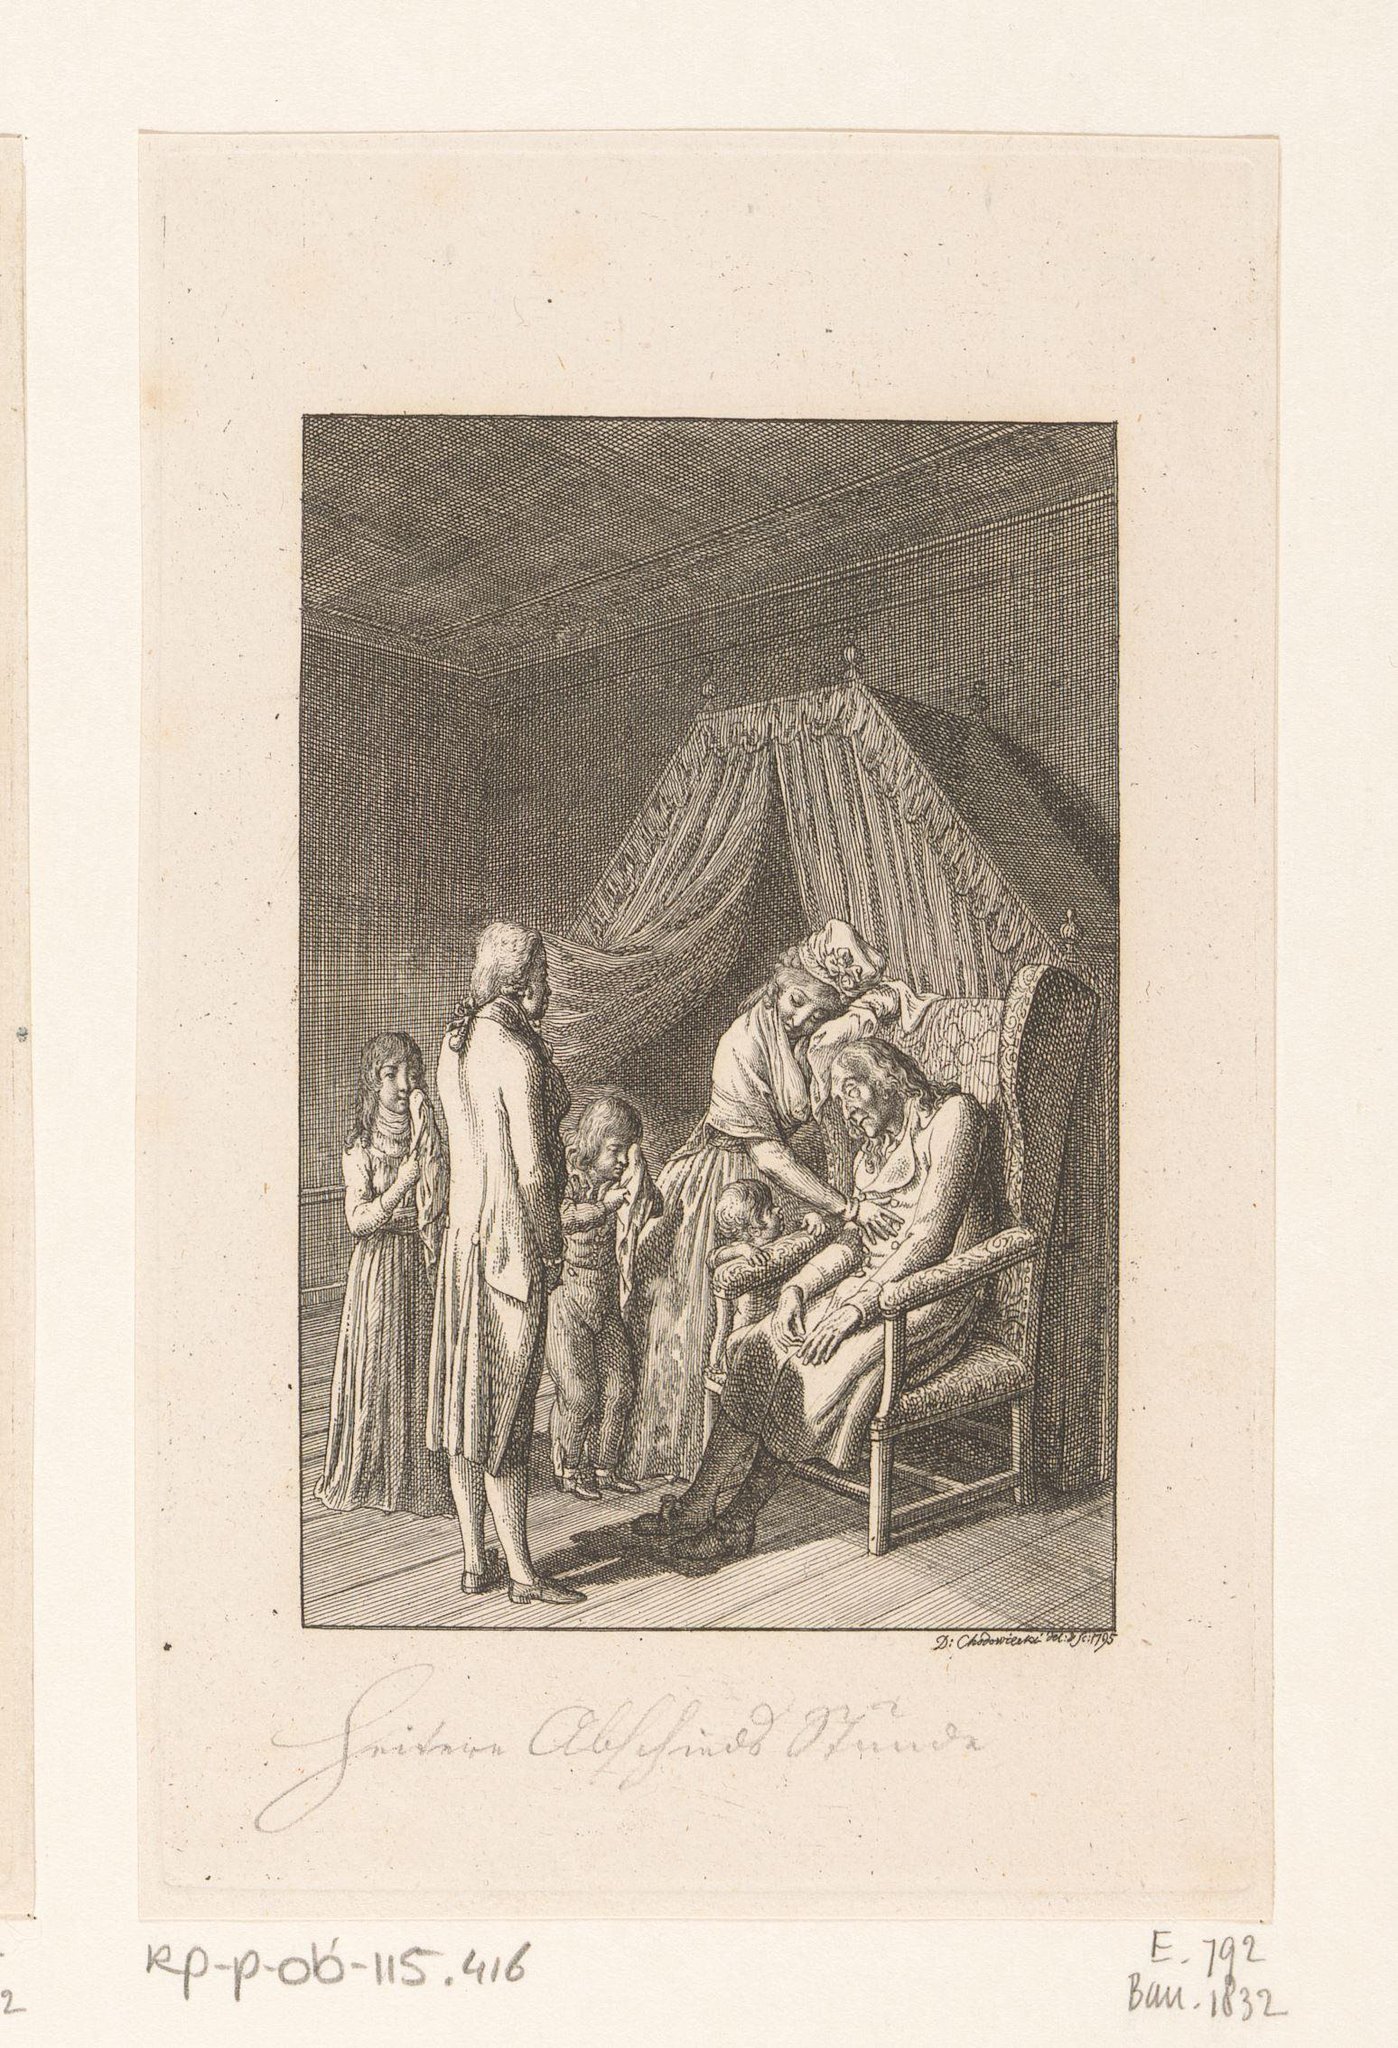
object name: print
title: Overlijden in gezelschap van liefdevolle familie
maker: daniel nikolaus chodowiecki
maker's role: draughtsman, print maker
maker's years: 1726-1801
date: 1795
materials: paper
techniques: etching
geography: berlin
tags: peaceful dying, happy death, family, relationship, descent, weeping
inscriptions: collector's mark: Lugt 2228, inscription: ‘Heitere Abschieds stunde’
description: Prent gebruikt voor: Lang, Carl. Almanach und Taschenbuch für Haeusliche u. Gesellschaftl. Freunden (...). [Frankfurt]: Heilbronn, 1797.